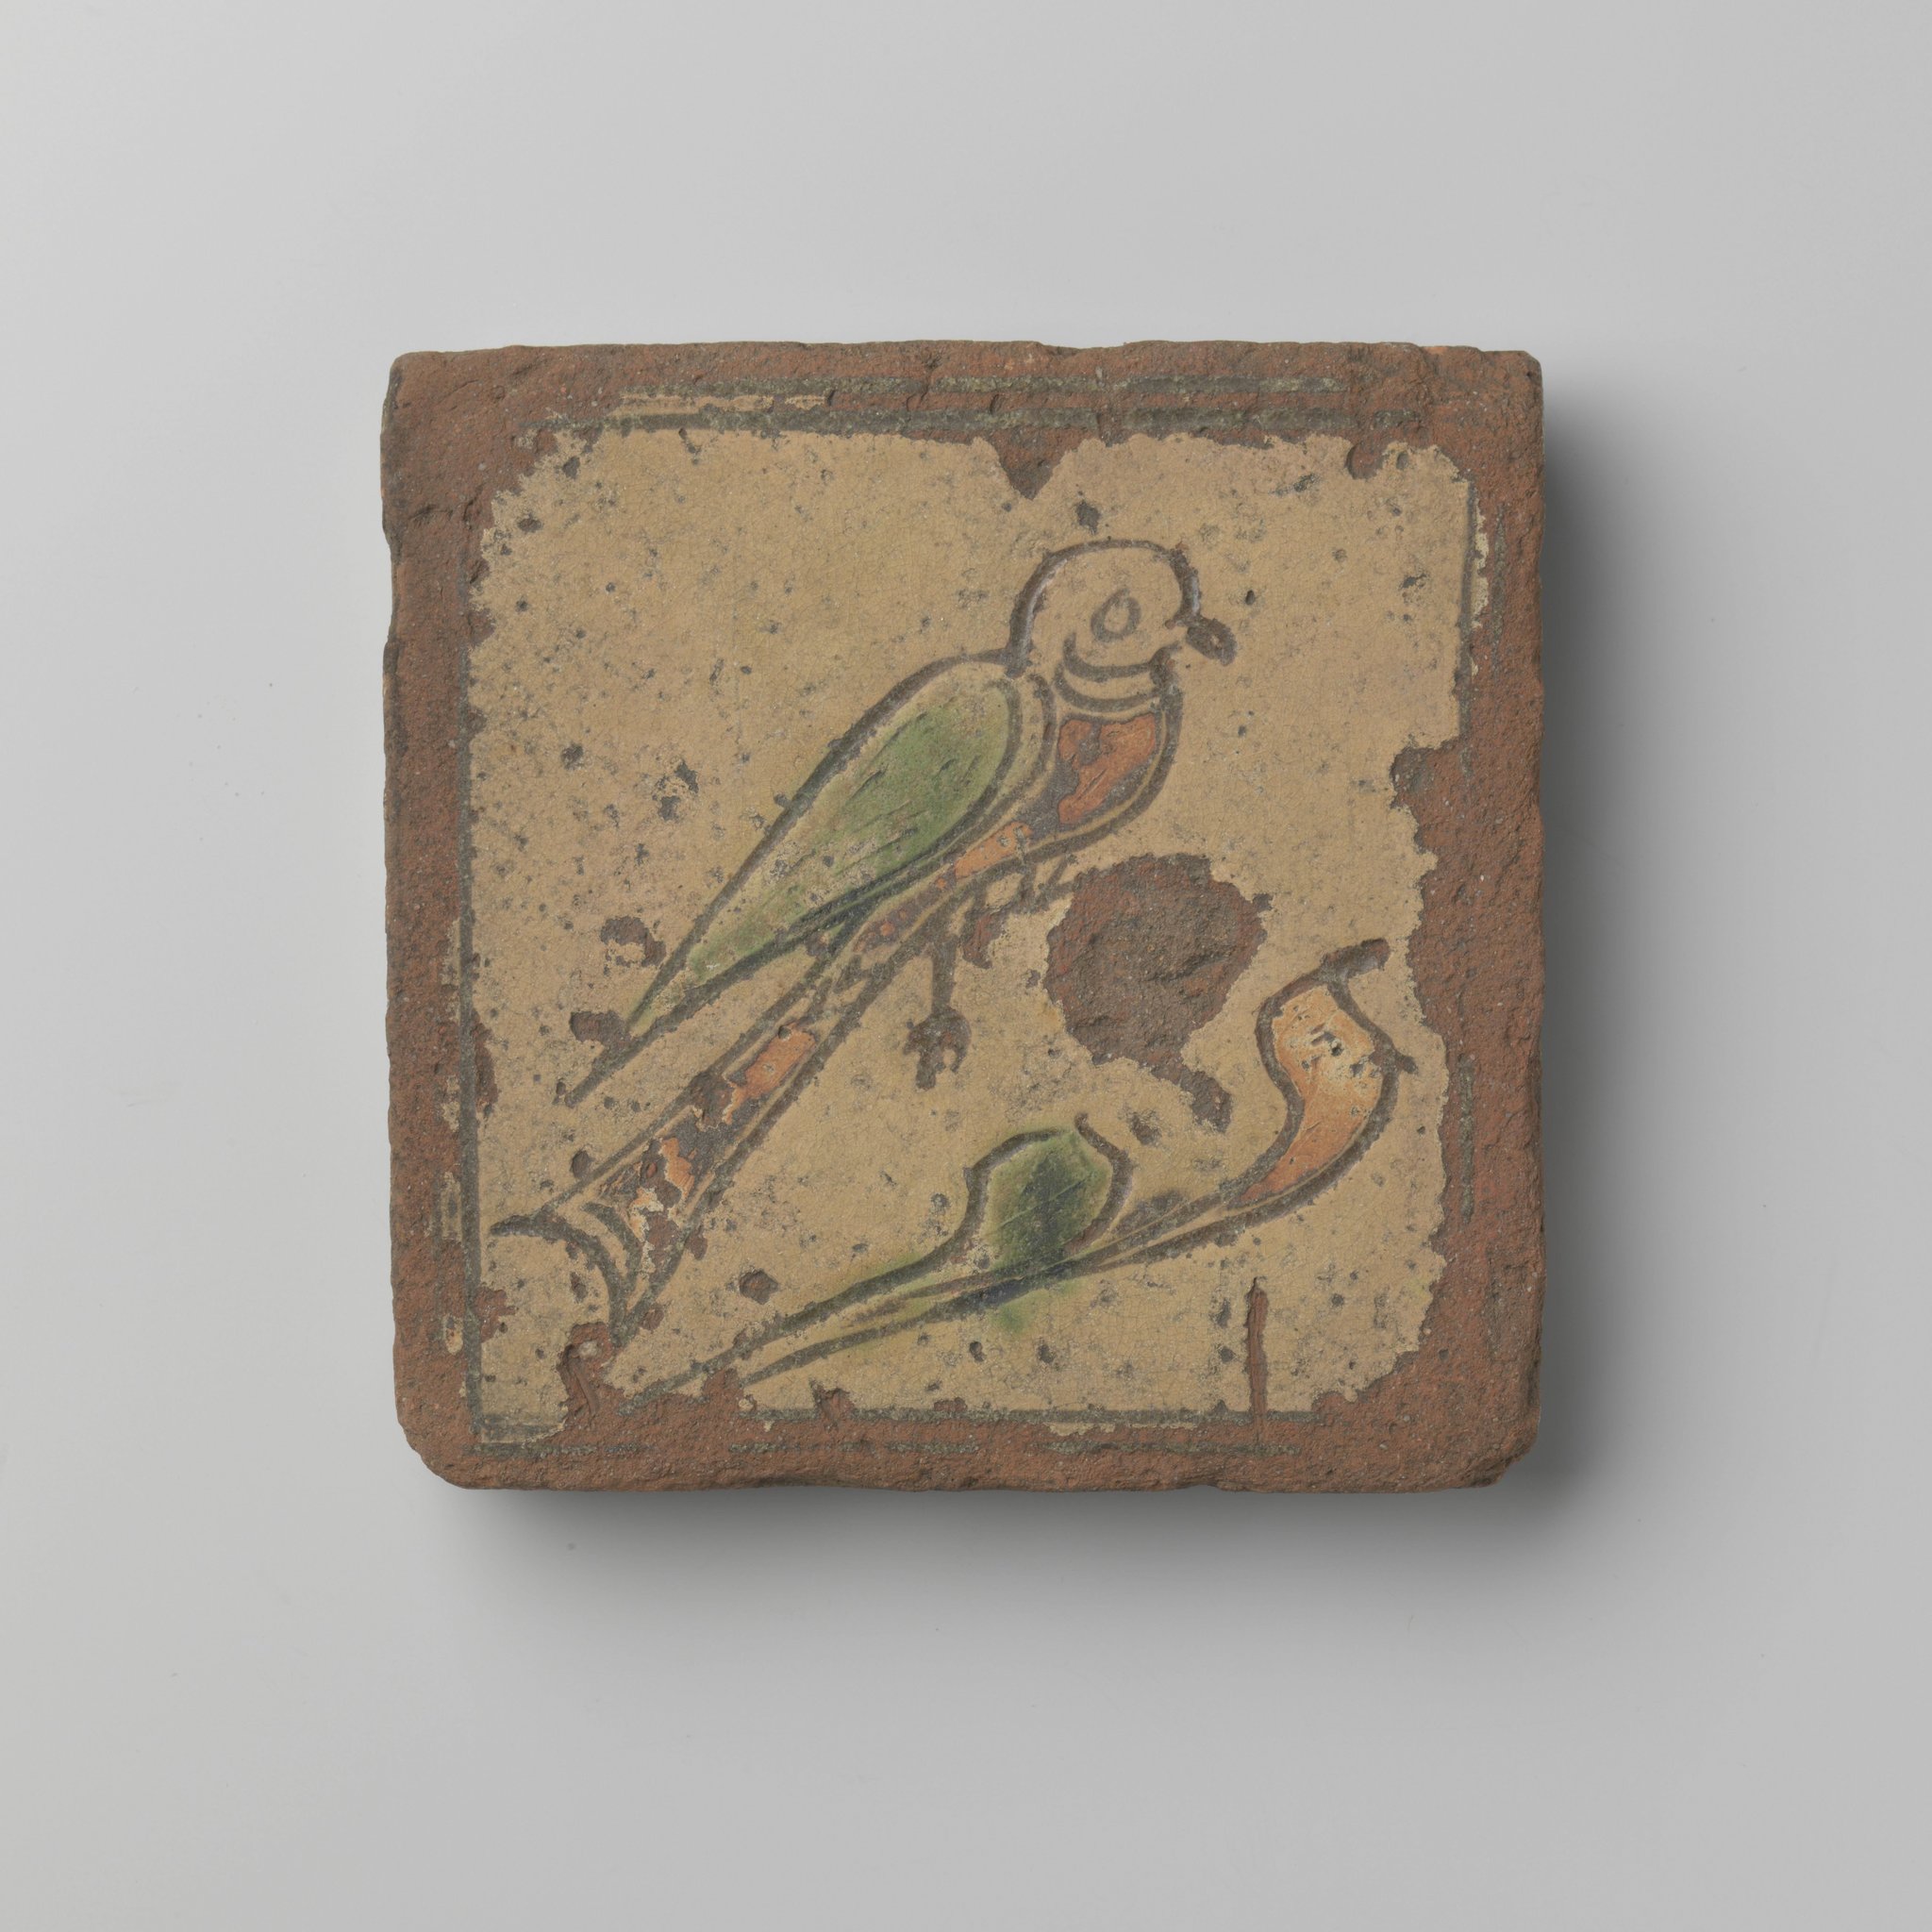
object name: tile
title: Tegel met duif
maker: Anonymous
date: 1700-1800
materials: earthenware, glaze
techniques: scoring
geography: limburg